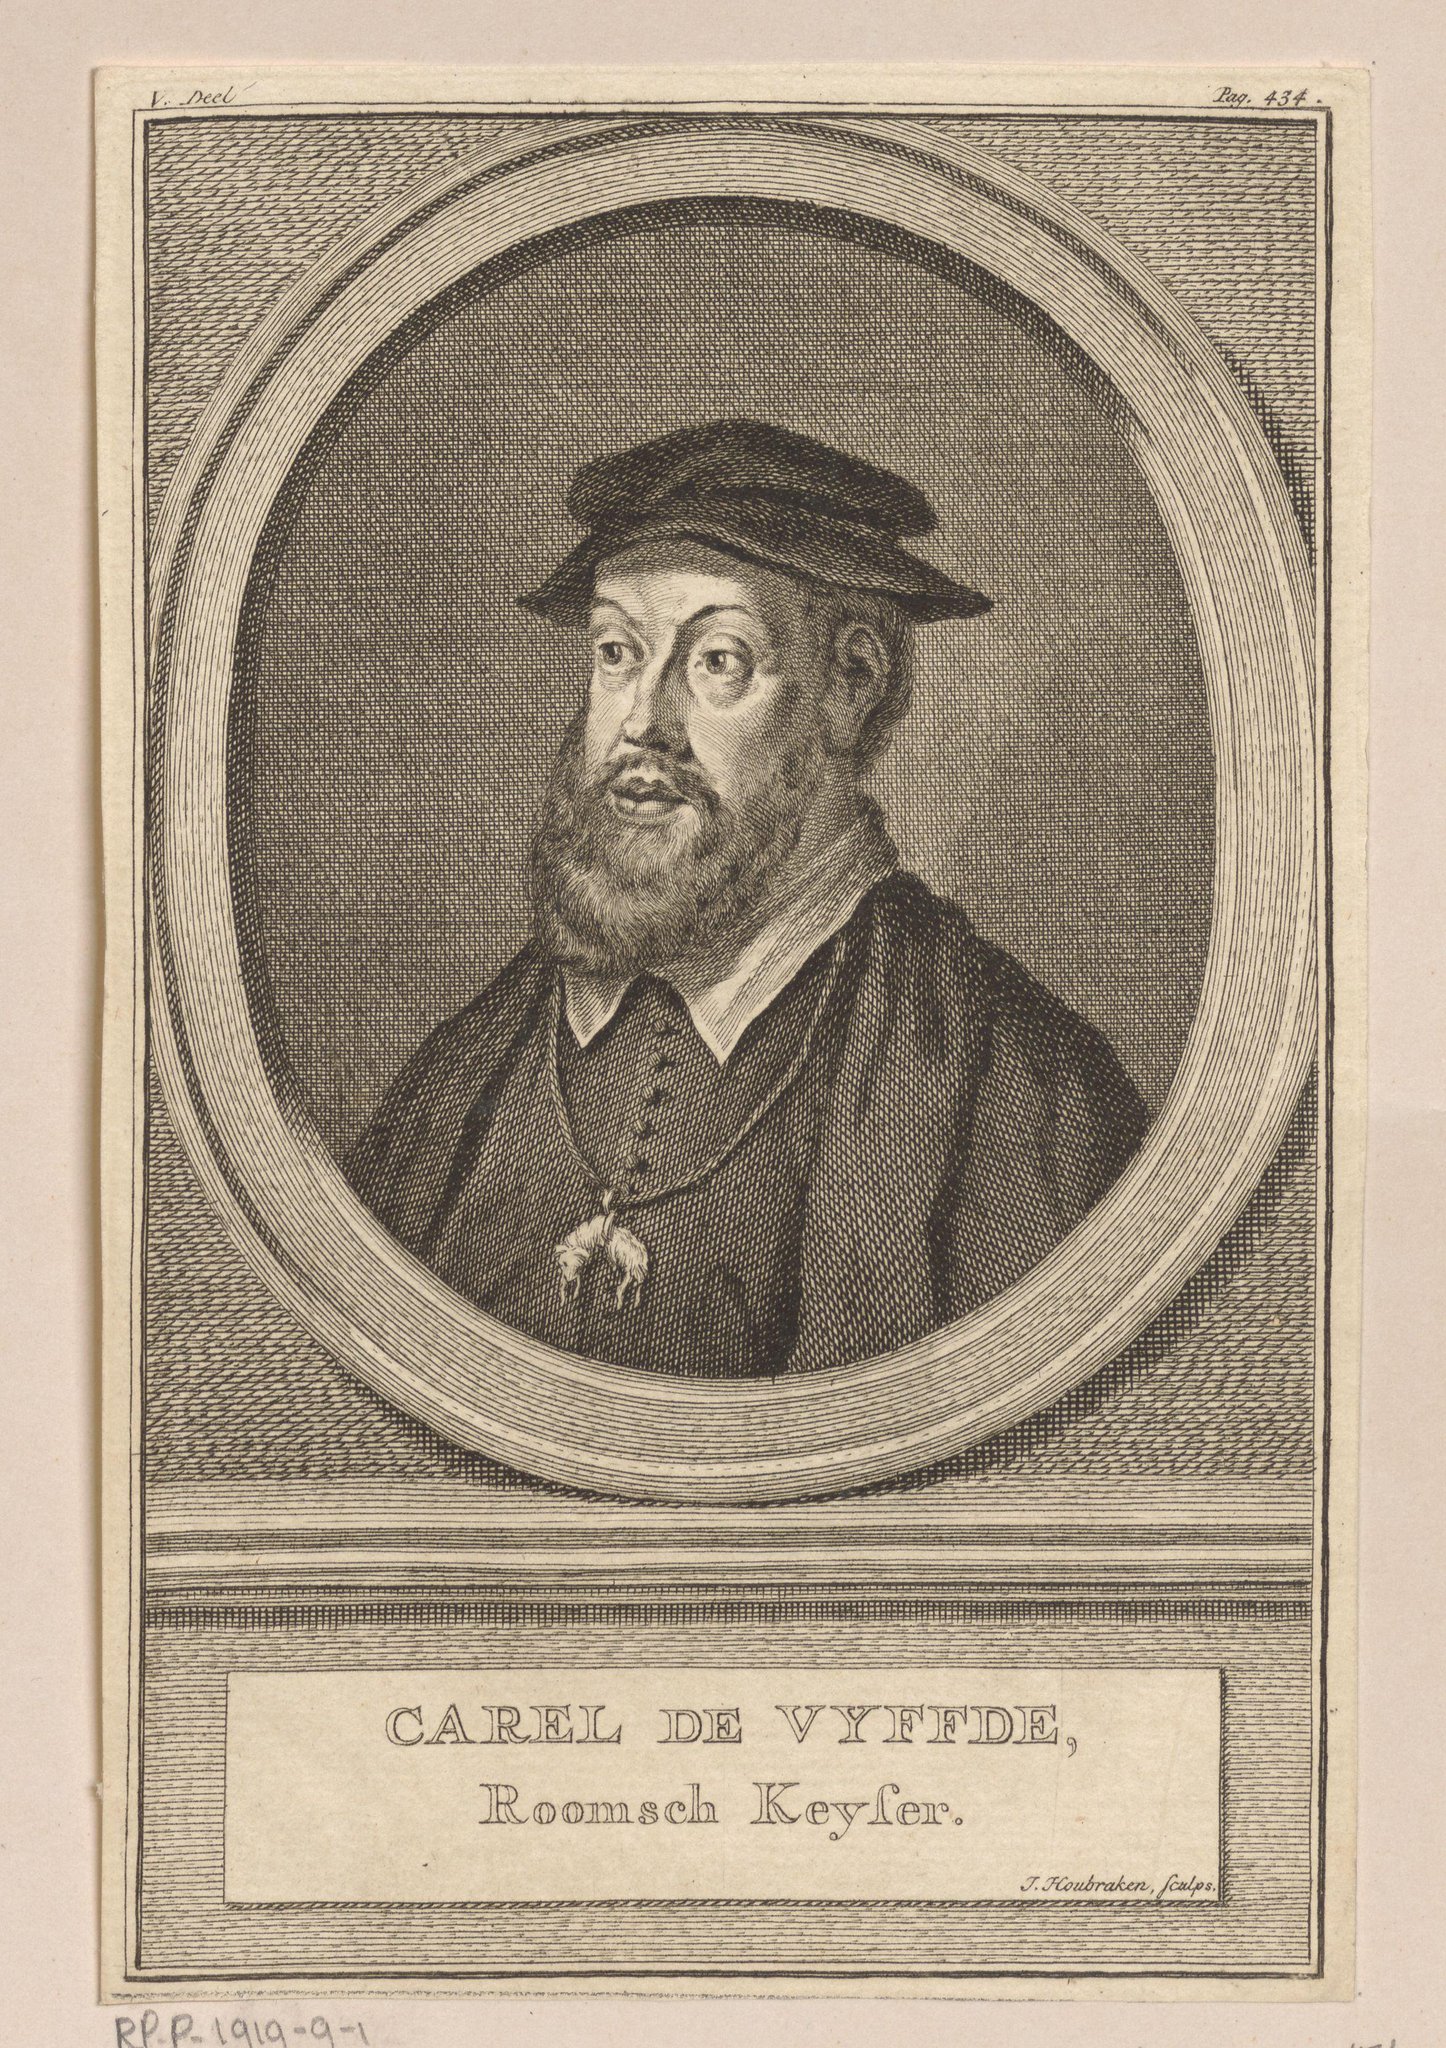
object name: print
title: Portret van keizer Karel V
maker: jacob houbraken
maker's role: draughtsman, print maker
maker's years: 1698-1780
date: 1791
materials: paper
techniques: engraving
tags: ghent, charles v (holy roman emperor and king of spain), historical persons, knighthood order of the golden fleece, king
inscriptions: collector's mark: Lugt 2228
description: Prent mogelijk uit: Wagenaar, Jan. Vaderlandsche historie, vervattende de geschiedenissen der nu Vereenigde Nederlanden (...). Amsterdam: Johannes Allart, 1791, dl. 5, p. 424.